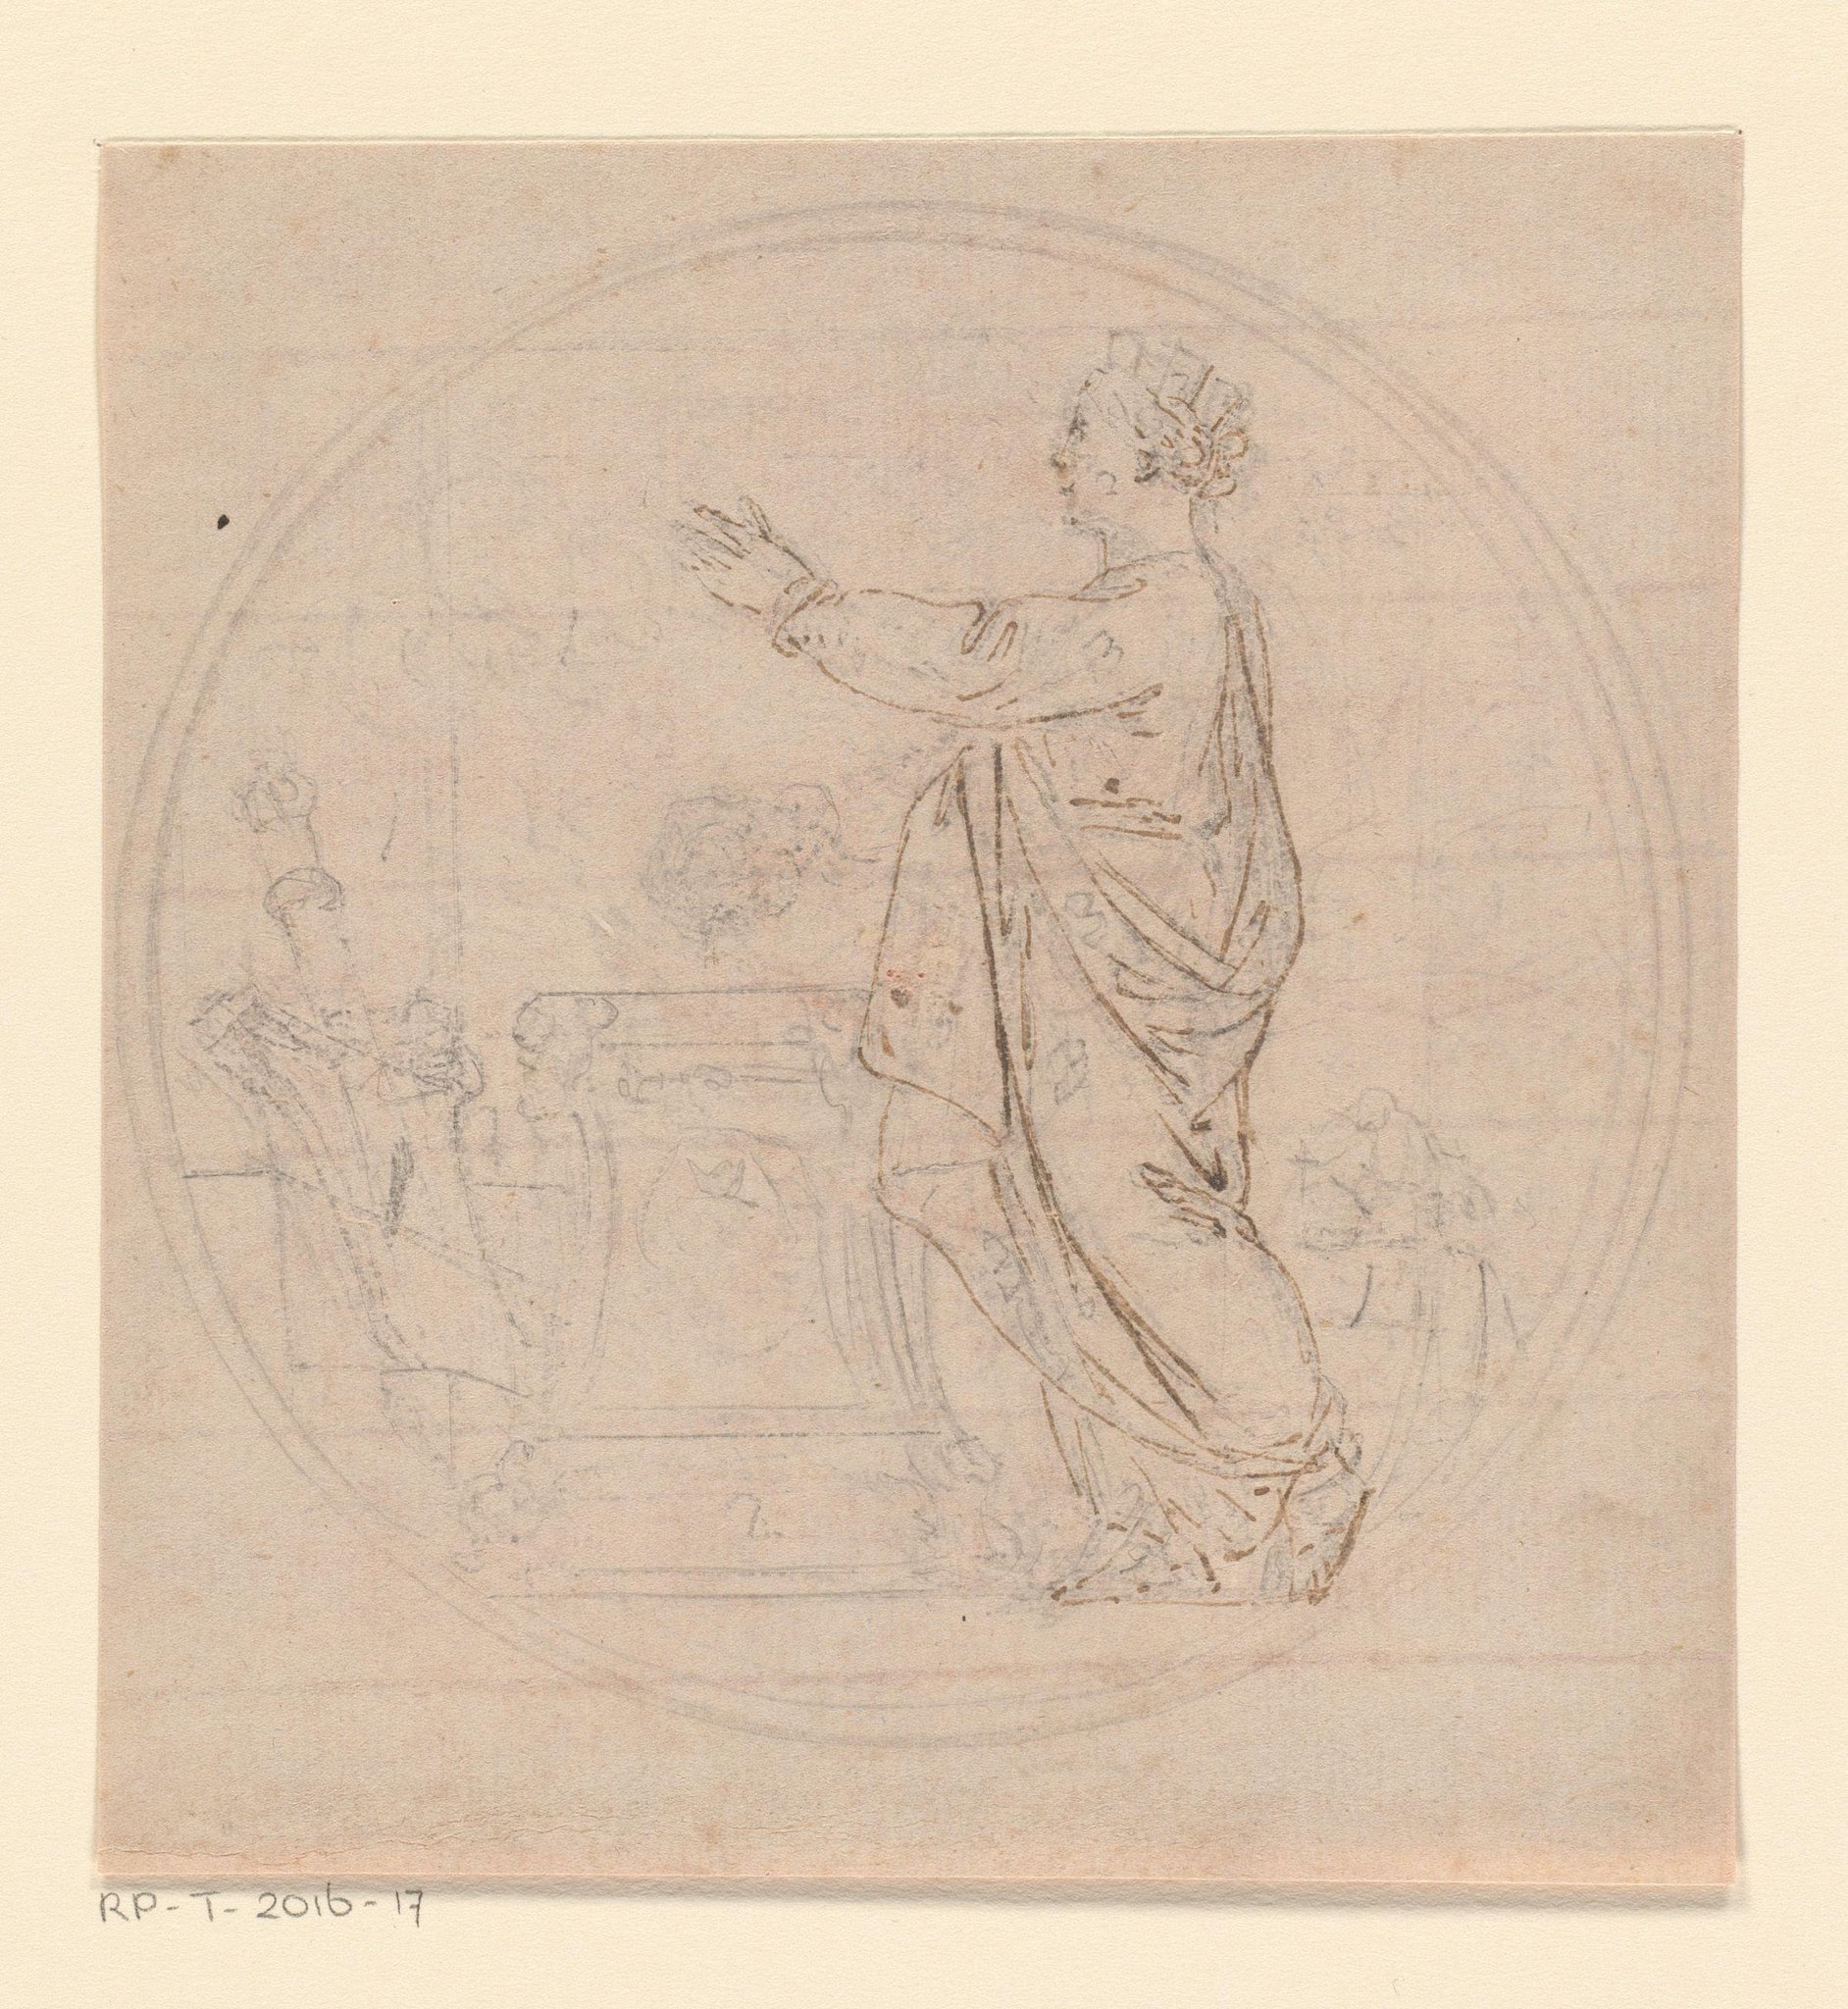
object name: drawing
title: Lopende figuur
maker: Anonymous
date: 1600-1800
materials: chalk, ink, paper, pencil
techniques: pen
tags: walking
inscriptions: collector's mark: Lugt 2228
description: Rond medaillon met een lopende figuur met de linkerhand naar voren gestoken. In de achtergrond een voetstuk of altaar.